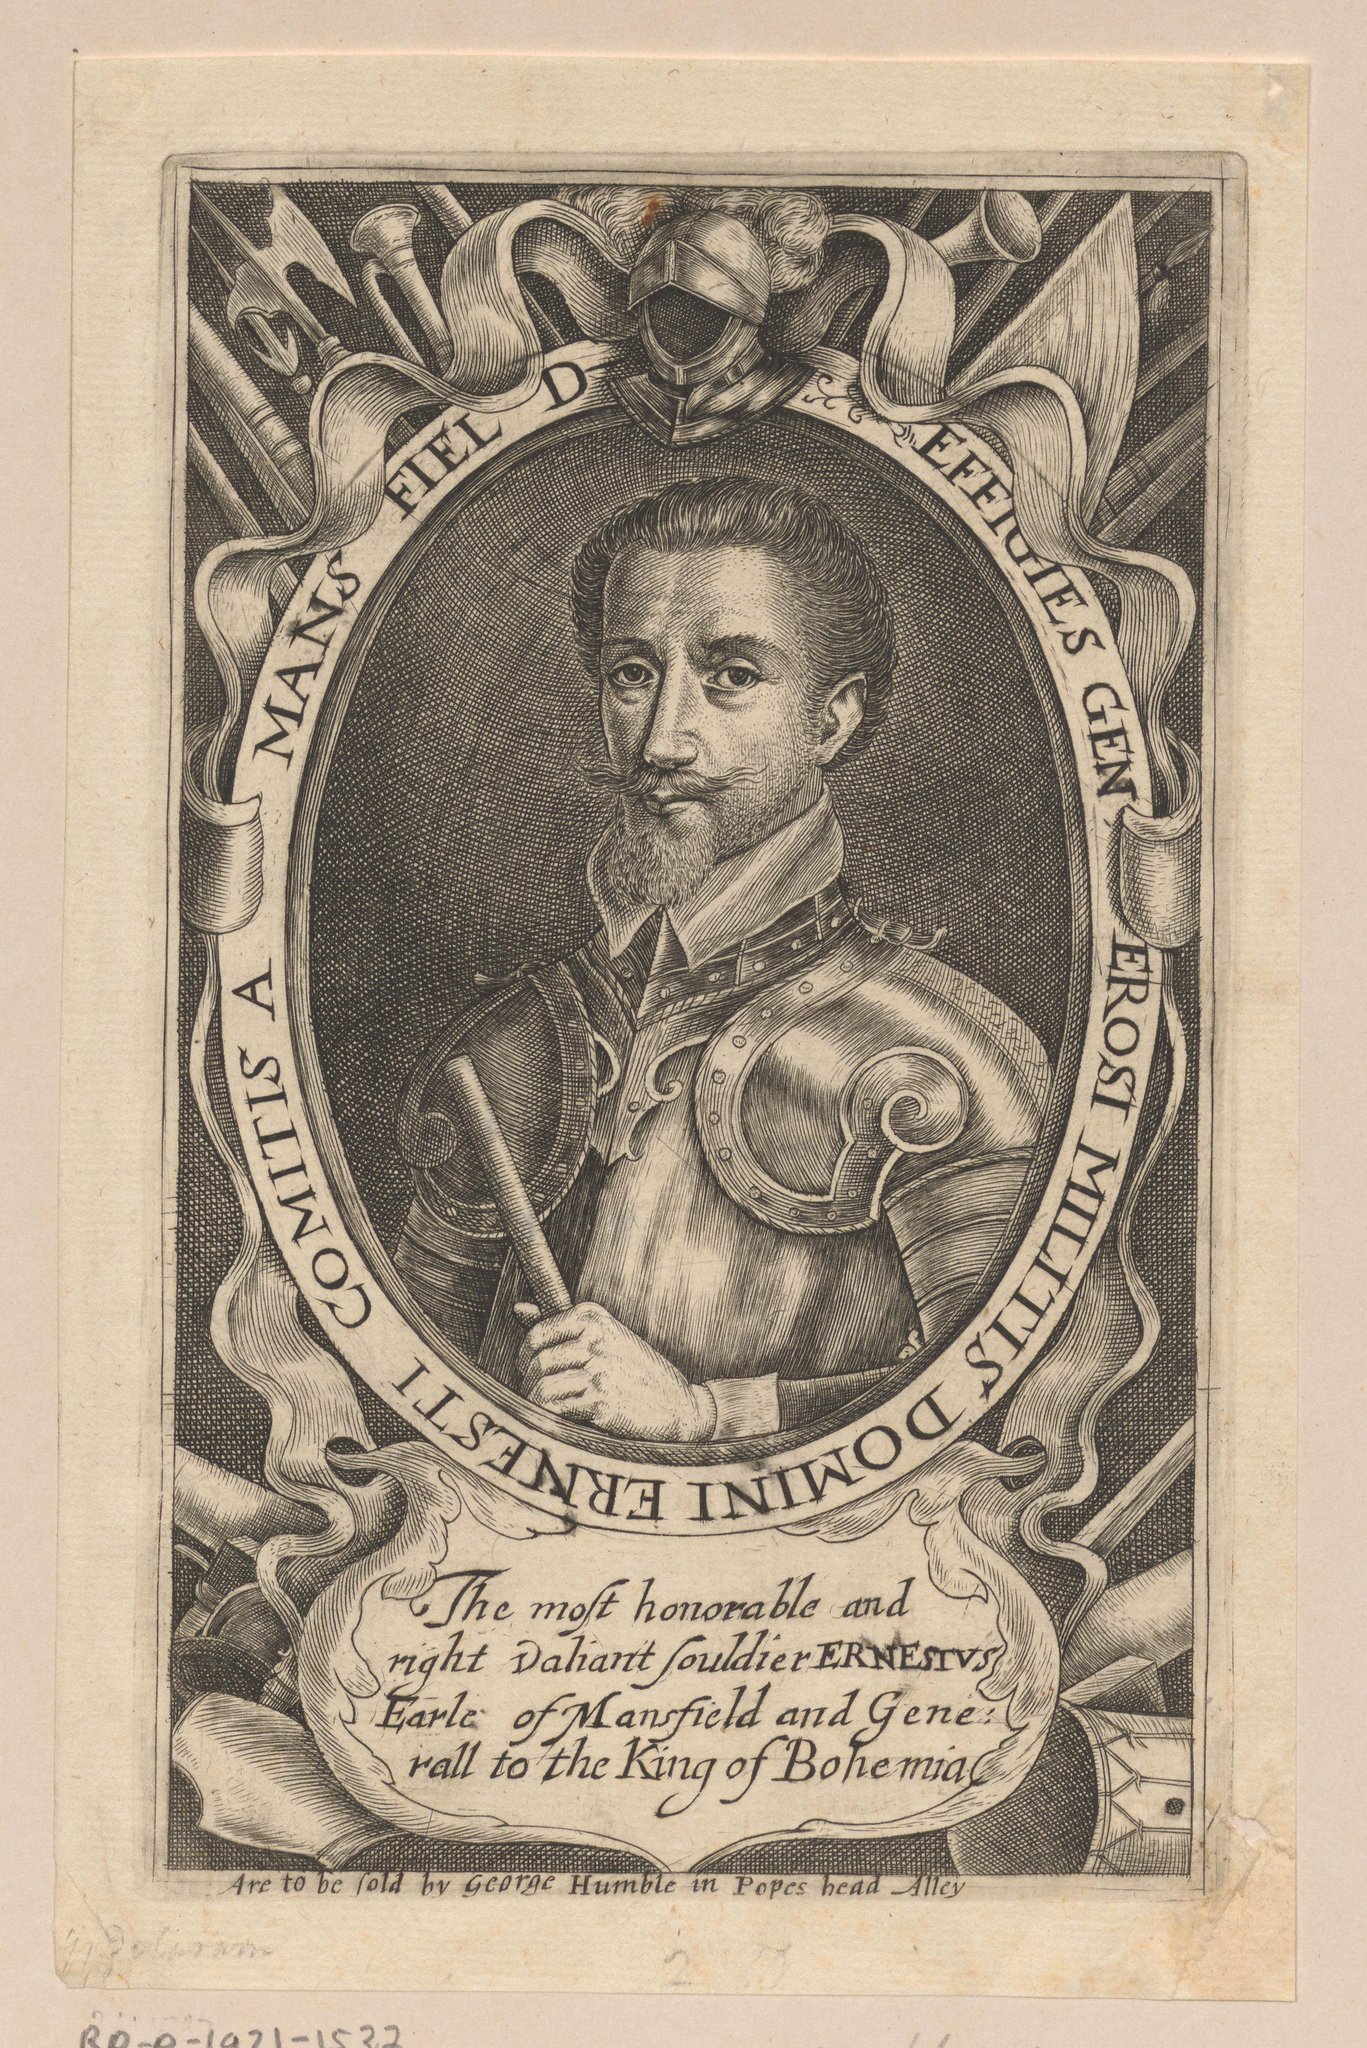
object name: print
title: Portret van Peter Ernst II van Mansfeld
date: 1603-1640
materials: paper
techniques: engraving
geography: london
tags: earl, peter ernst von mansfeld (graaf), helmet, ornament ~ medallion, commander-in-chief, general, marshal, armour, historical persons, ornament ~ cartouche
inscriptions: collector's mark: Lugt 2233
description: Met vierregelig onderschrift in het Engels.